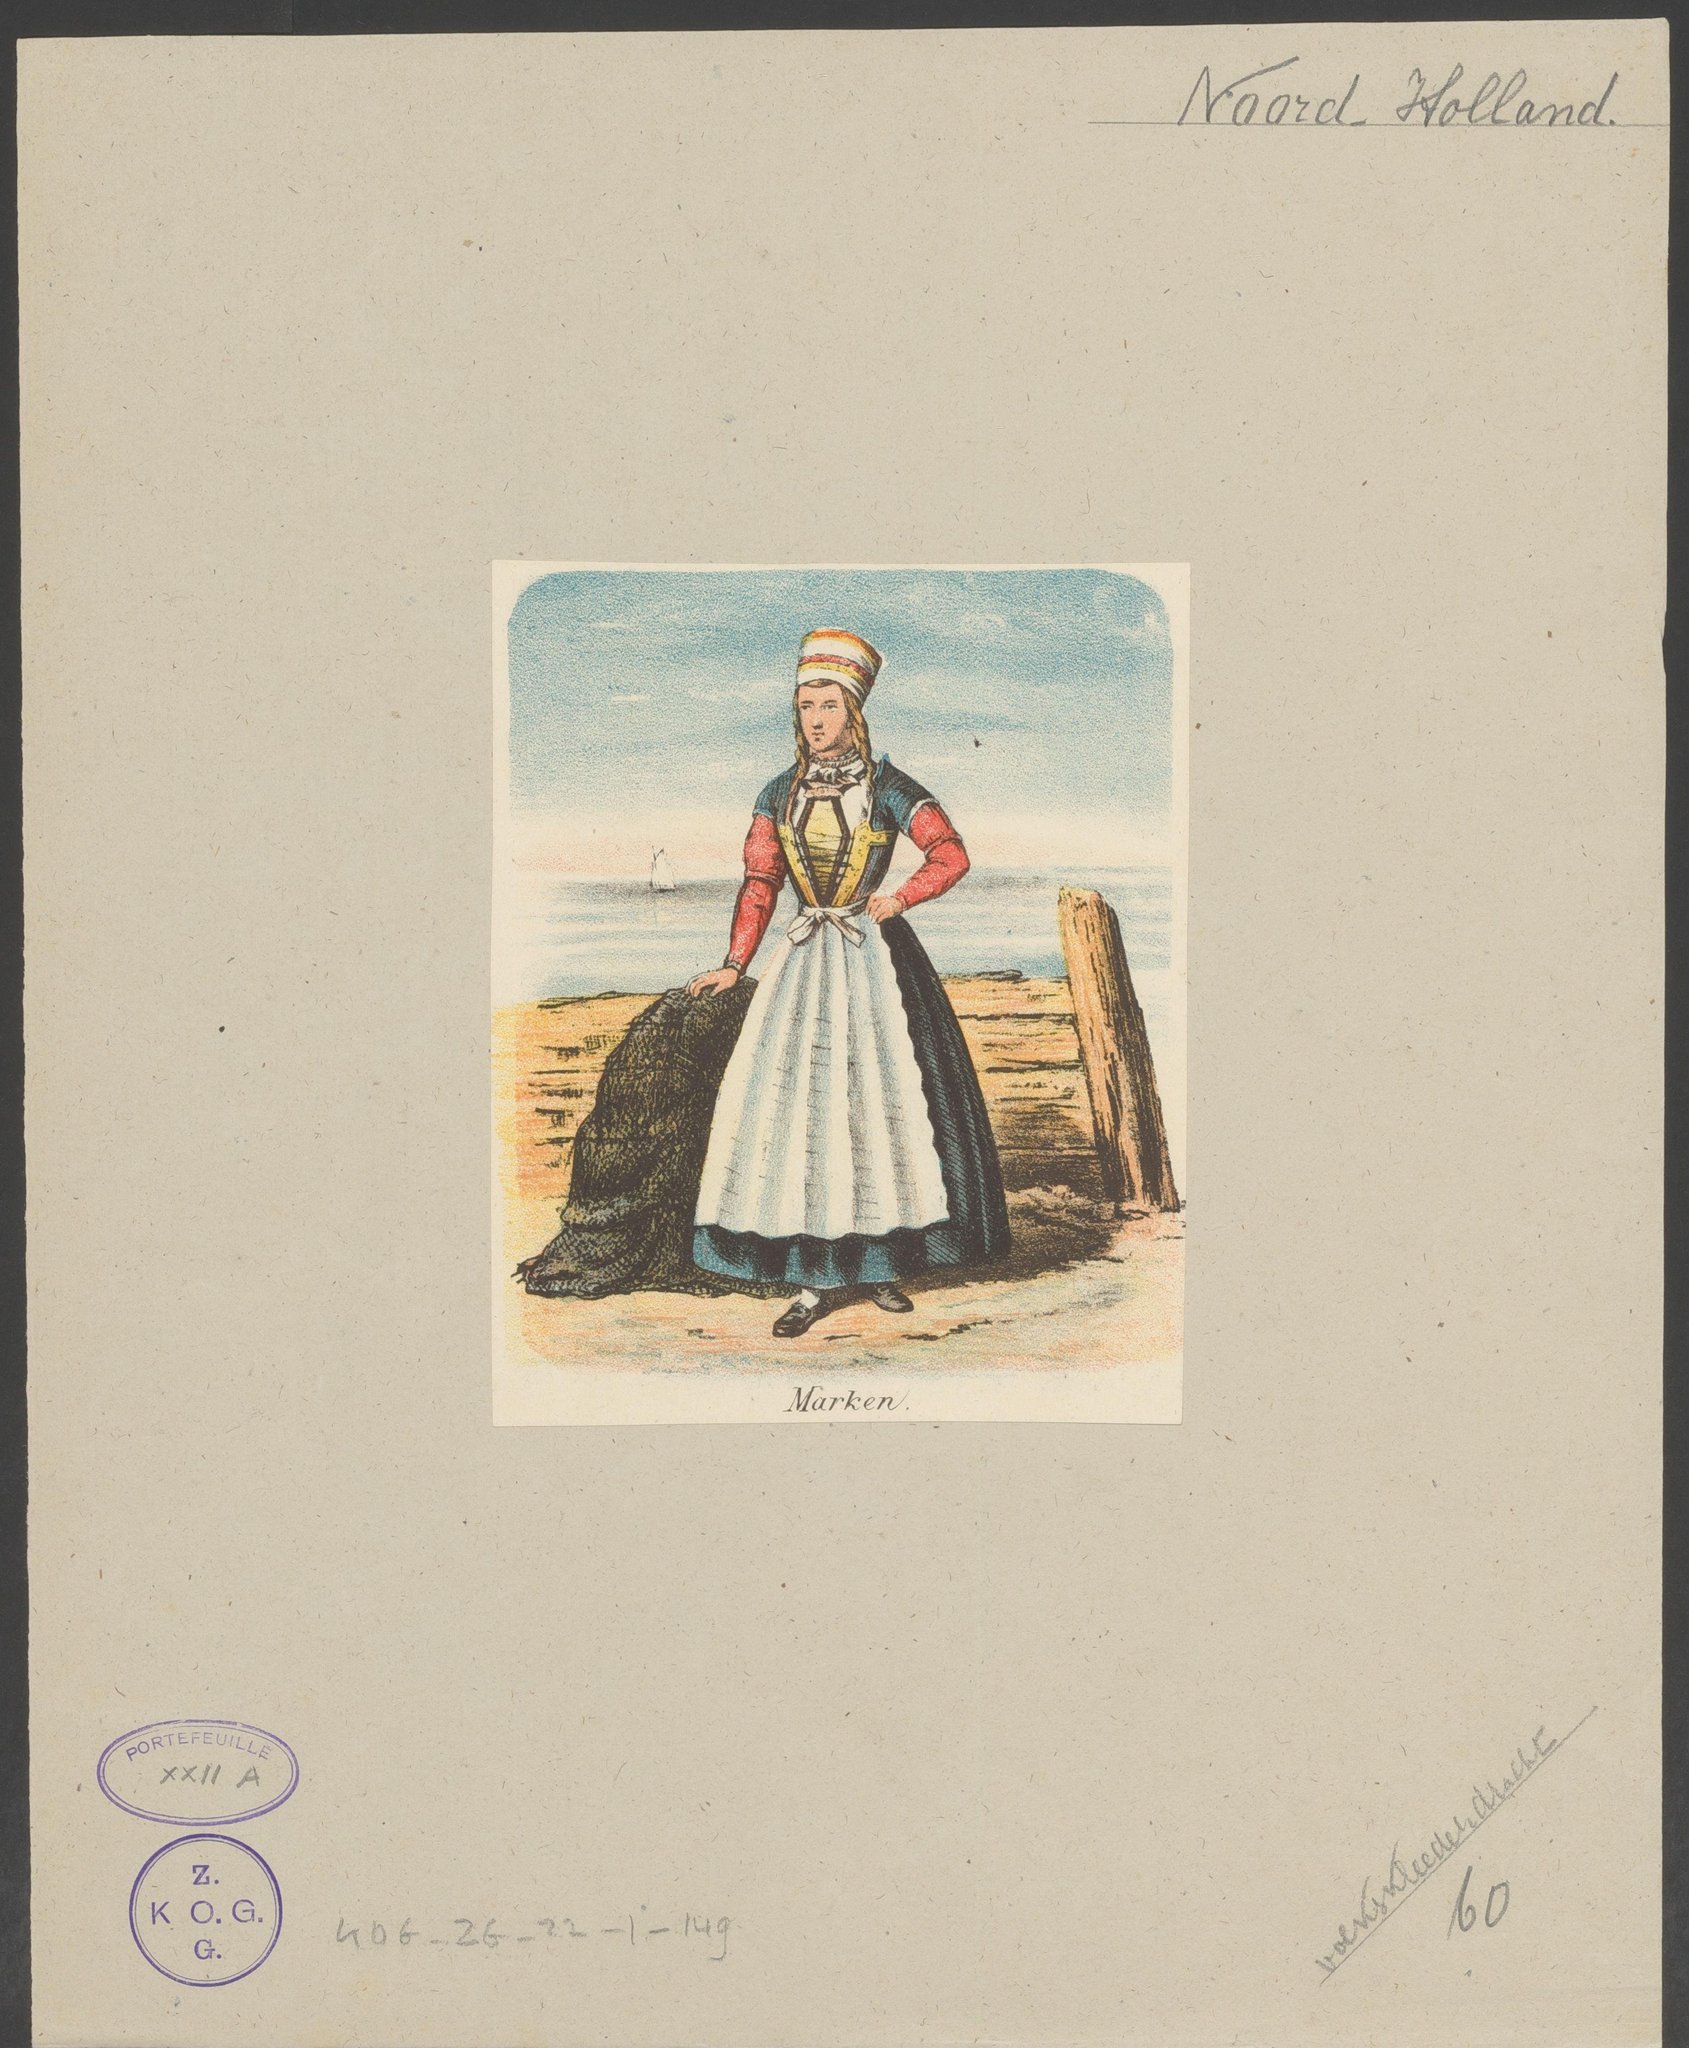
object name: print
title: Marken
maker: Anonymous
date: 1880-1930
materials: paper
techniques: lithograph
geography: netherlands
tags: sea and coastal fishery (+ women (labourers)), clothes, costume (+ women's clothes), folk costume, regional costume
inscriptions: collector's mark, collector's mark: Lugt 1641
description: Vissersvrouw van Marken, staande bij een hek waarover een visnet te drogen hangt. Onderwerpsrubrieken binnen de Atlas Zeden en Gewoonten: De Kleeding, Volkskleederdracht, Noord-Holland.